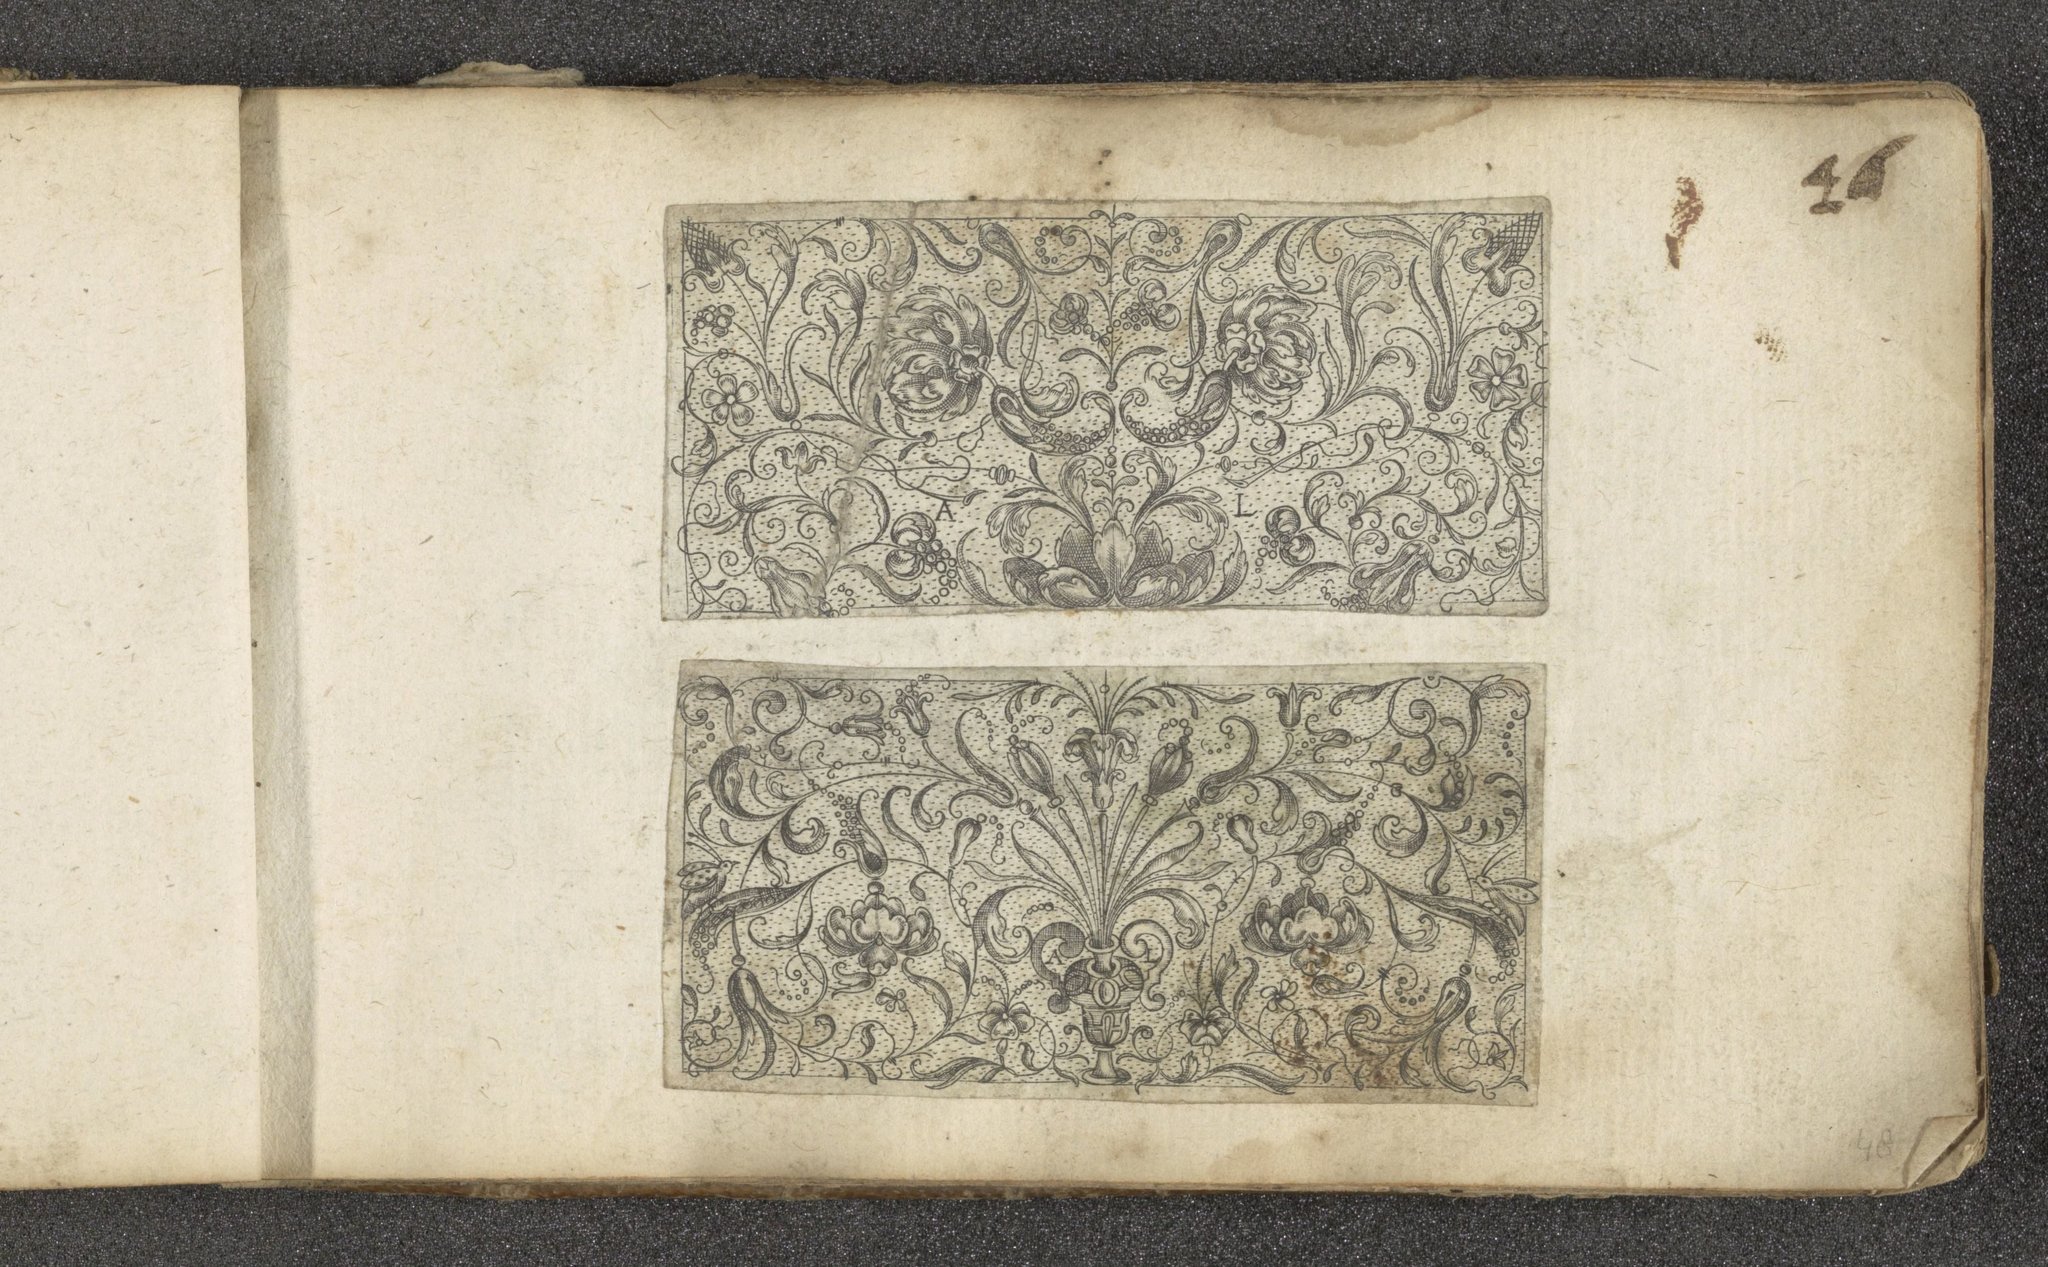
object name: ornament print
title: Randdecoratie met twee bloemen en bladwerk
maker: andreas luining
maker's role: publisher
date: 1589-1593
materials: paper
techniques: engraving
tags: ornaments ~ art, foliage ~ ornament, ornament ~ arabesque, flowers ~ ornament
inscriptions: inscription: ‘46’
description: Randdecoratie met twee bloemen en bladwerk, tegen een gespikkelde achtergrond. De prent maakt deel uit van een album.